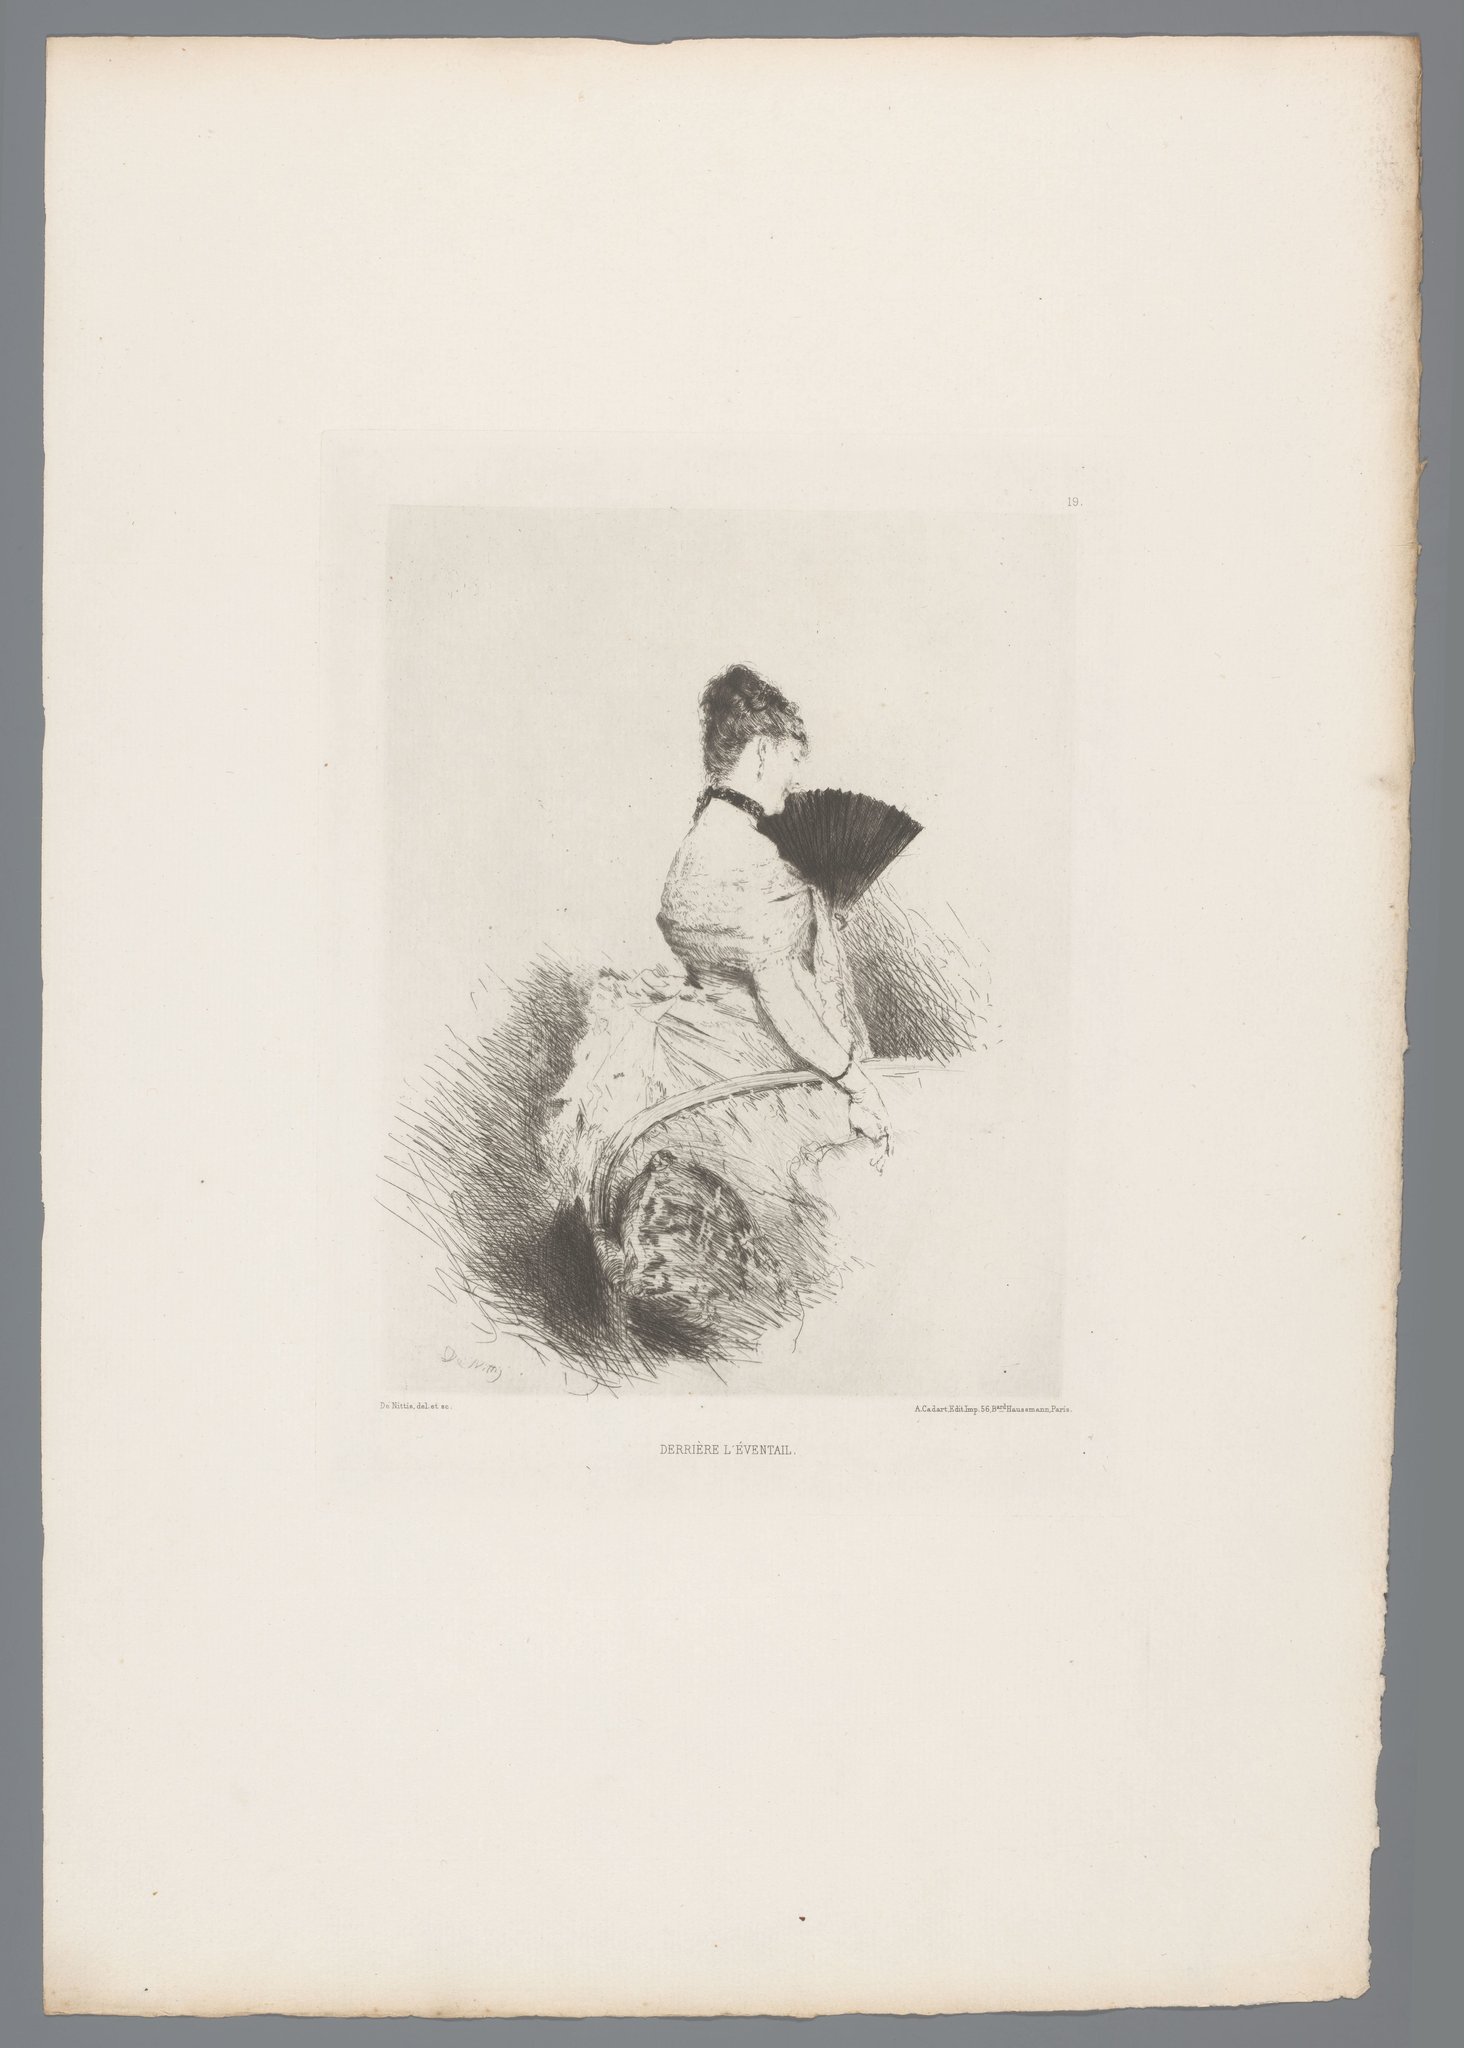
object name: print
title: Franse etsen uit 1875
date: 1875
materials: paper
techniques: drypoint, etching, intaglio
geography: paris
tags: sitting figure - aa - female human figure, fan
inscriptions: collector's mark: Lugt 2760, collector's mark: ‘AFE v S’, collector's mark: Lugt 2228